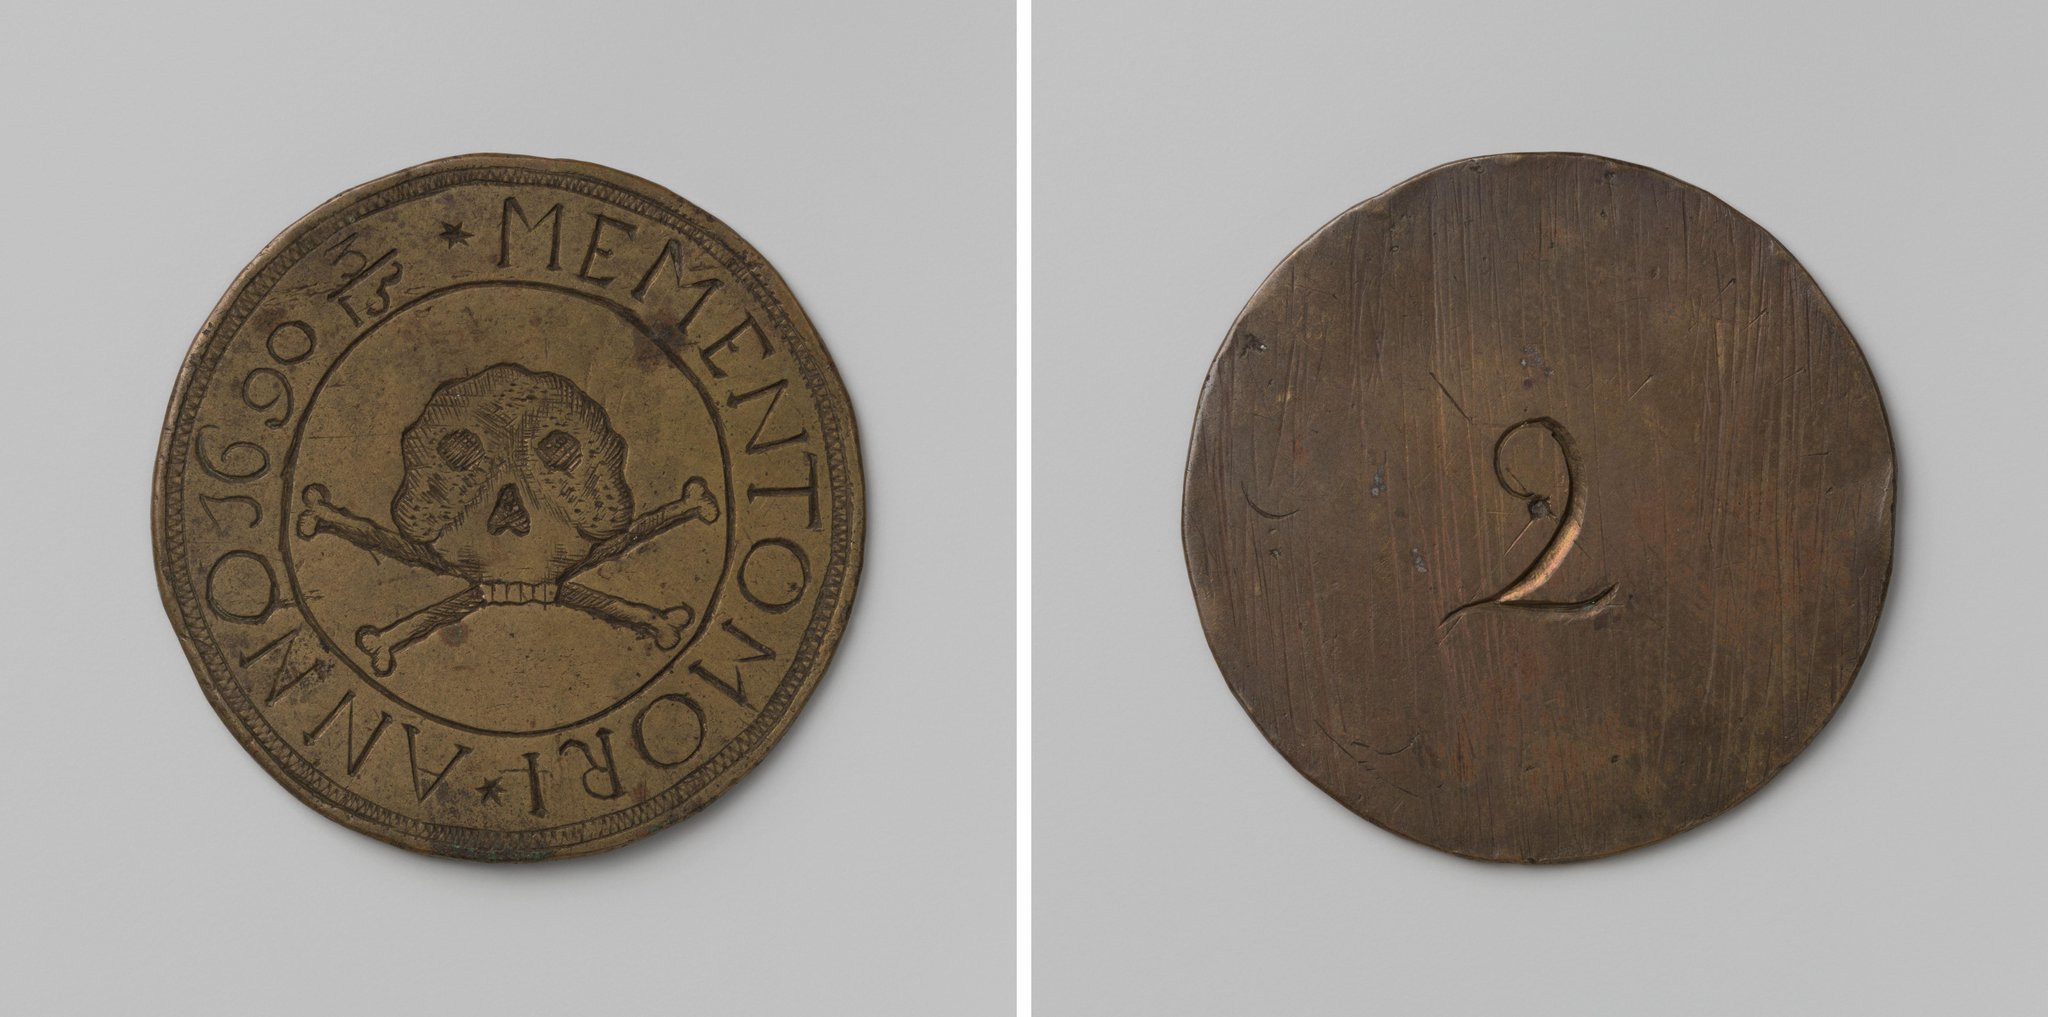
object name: funeral token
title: Begrafenispenning met no. 2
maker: Anonymous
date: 1690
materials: brass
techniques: engraving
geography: netherlands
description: Messing penning. Voorzijde: doodshoofd boven twee gekruiste beenderen binnen omschrift. Keerzijde: cijfer 2. Mogelijk een buurtpenning of begrafenispenning.